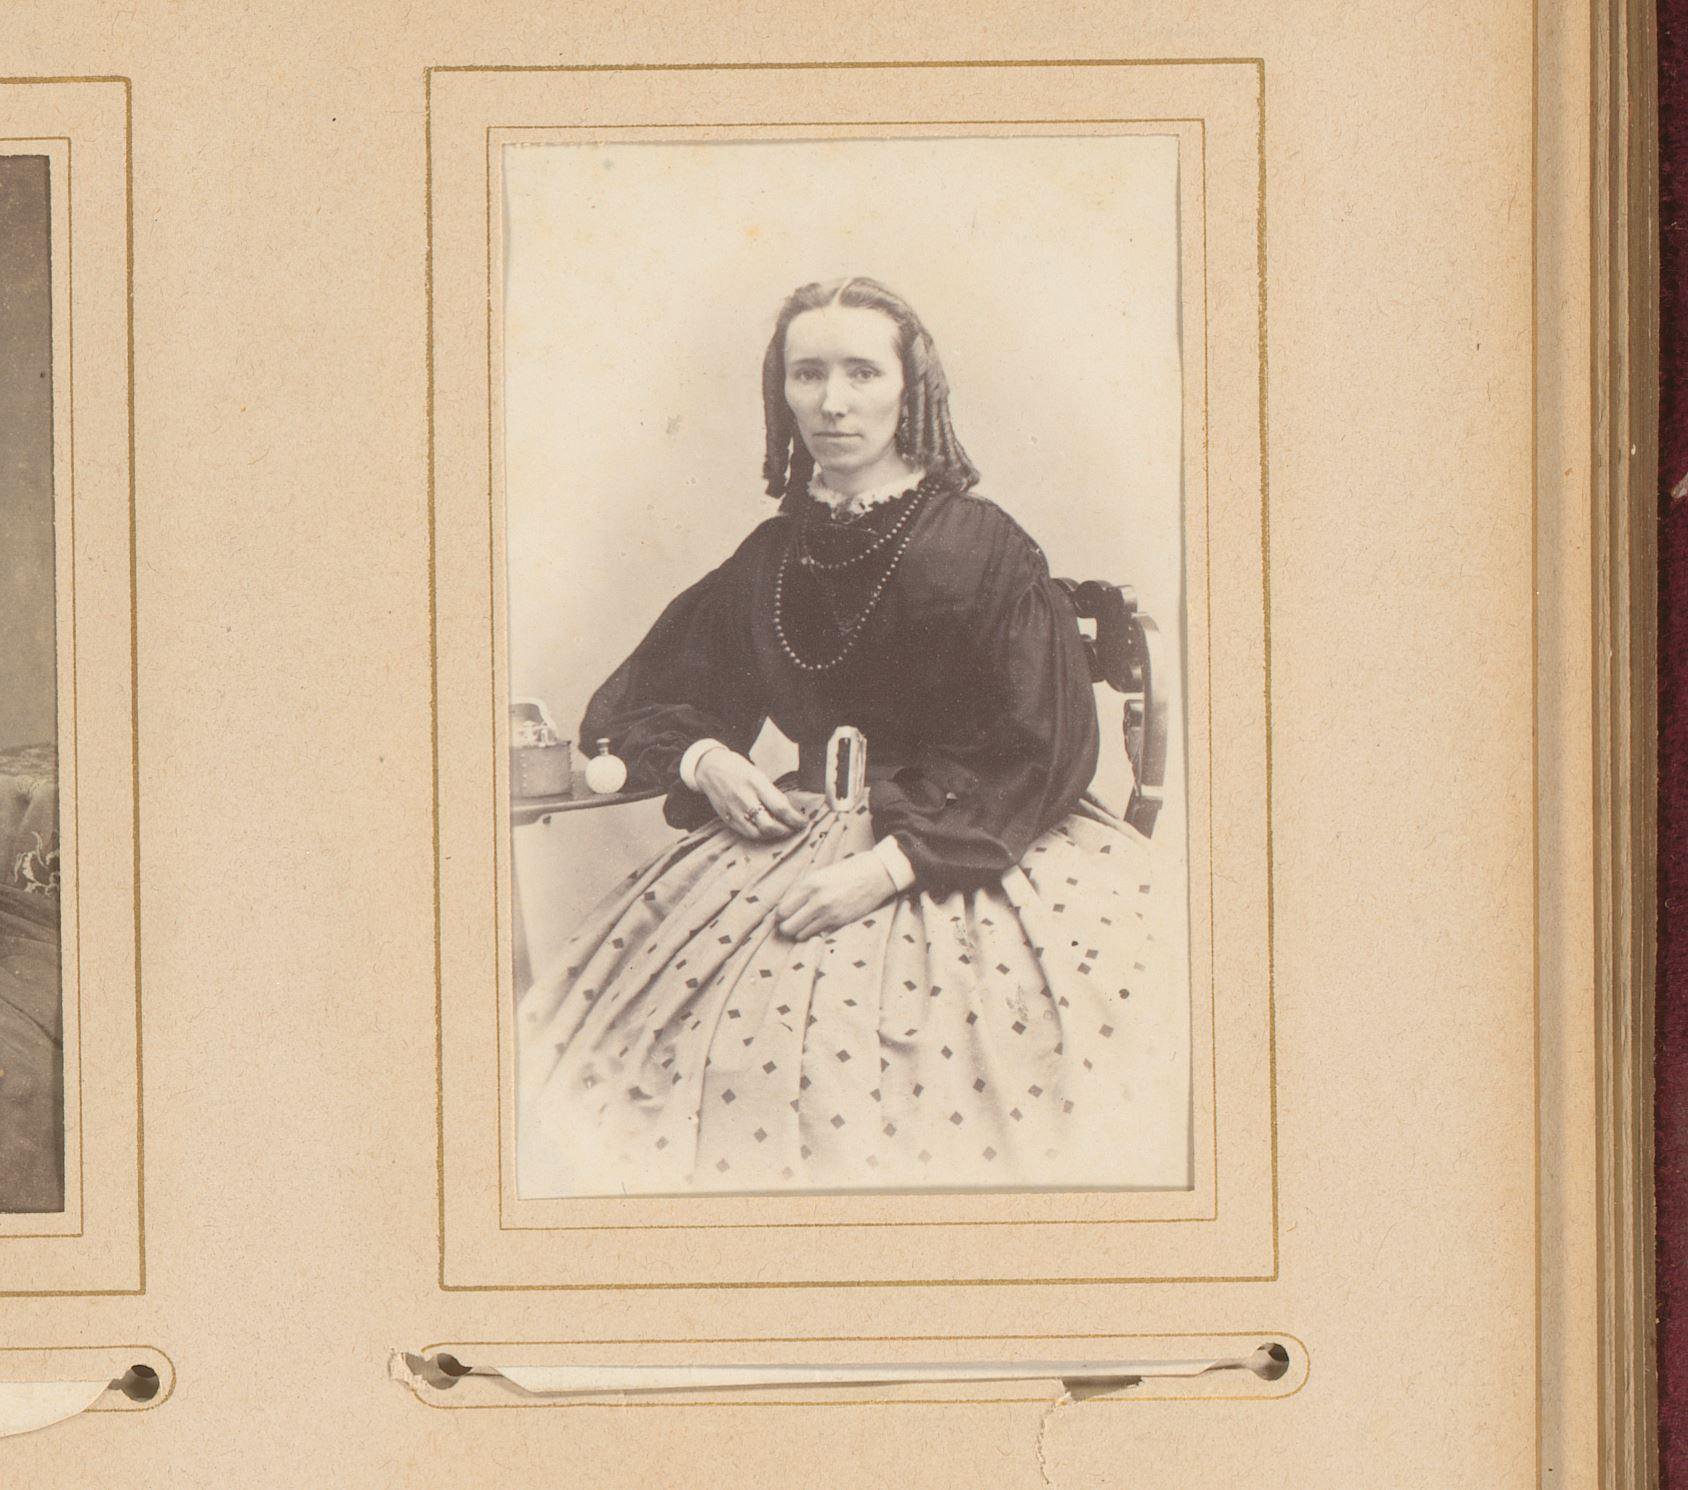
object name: carte de visite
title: Portret van een vrouw met pijpenkrullen bij een tafel met reukwaterfles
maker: emanuel lorjé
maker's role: fotograaf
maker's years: 1845-1875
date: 1867-1875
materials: cardboard, photographic support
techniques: albumen print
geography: netherlands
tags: perfume bottle, historical persons - bb - woman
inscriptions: inscription: ‘E. Lorjé. Phot:’